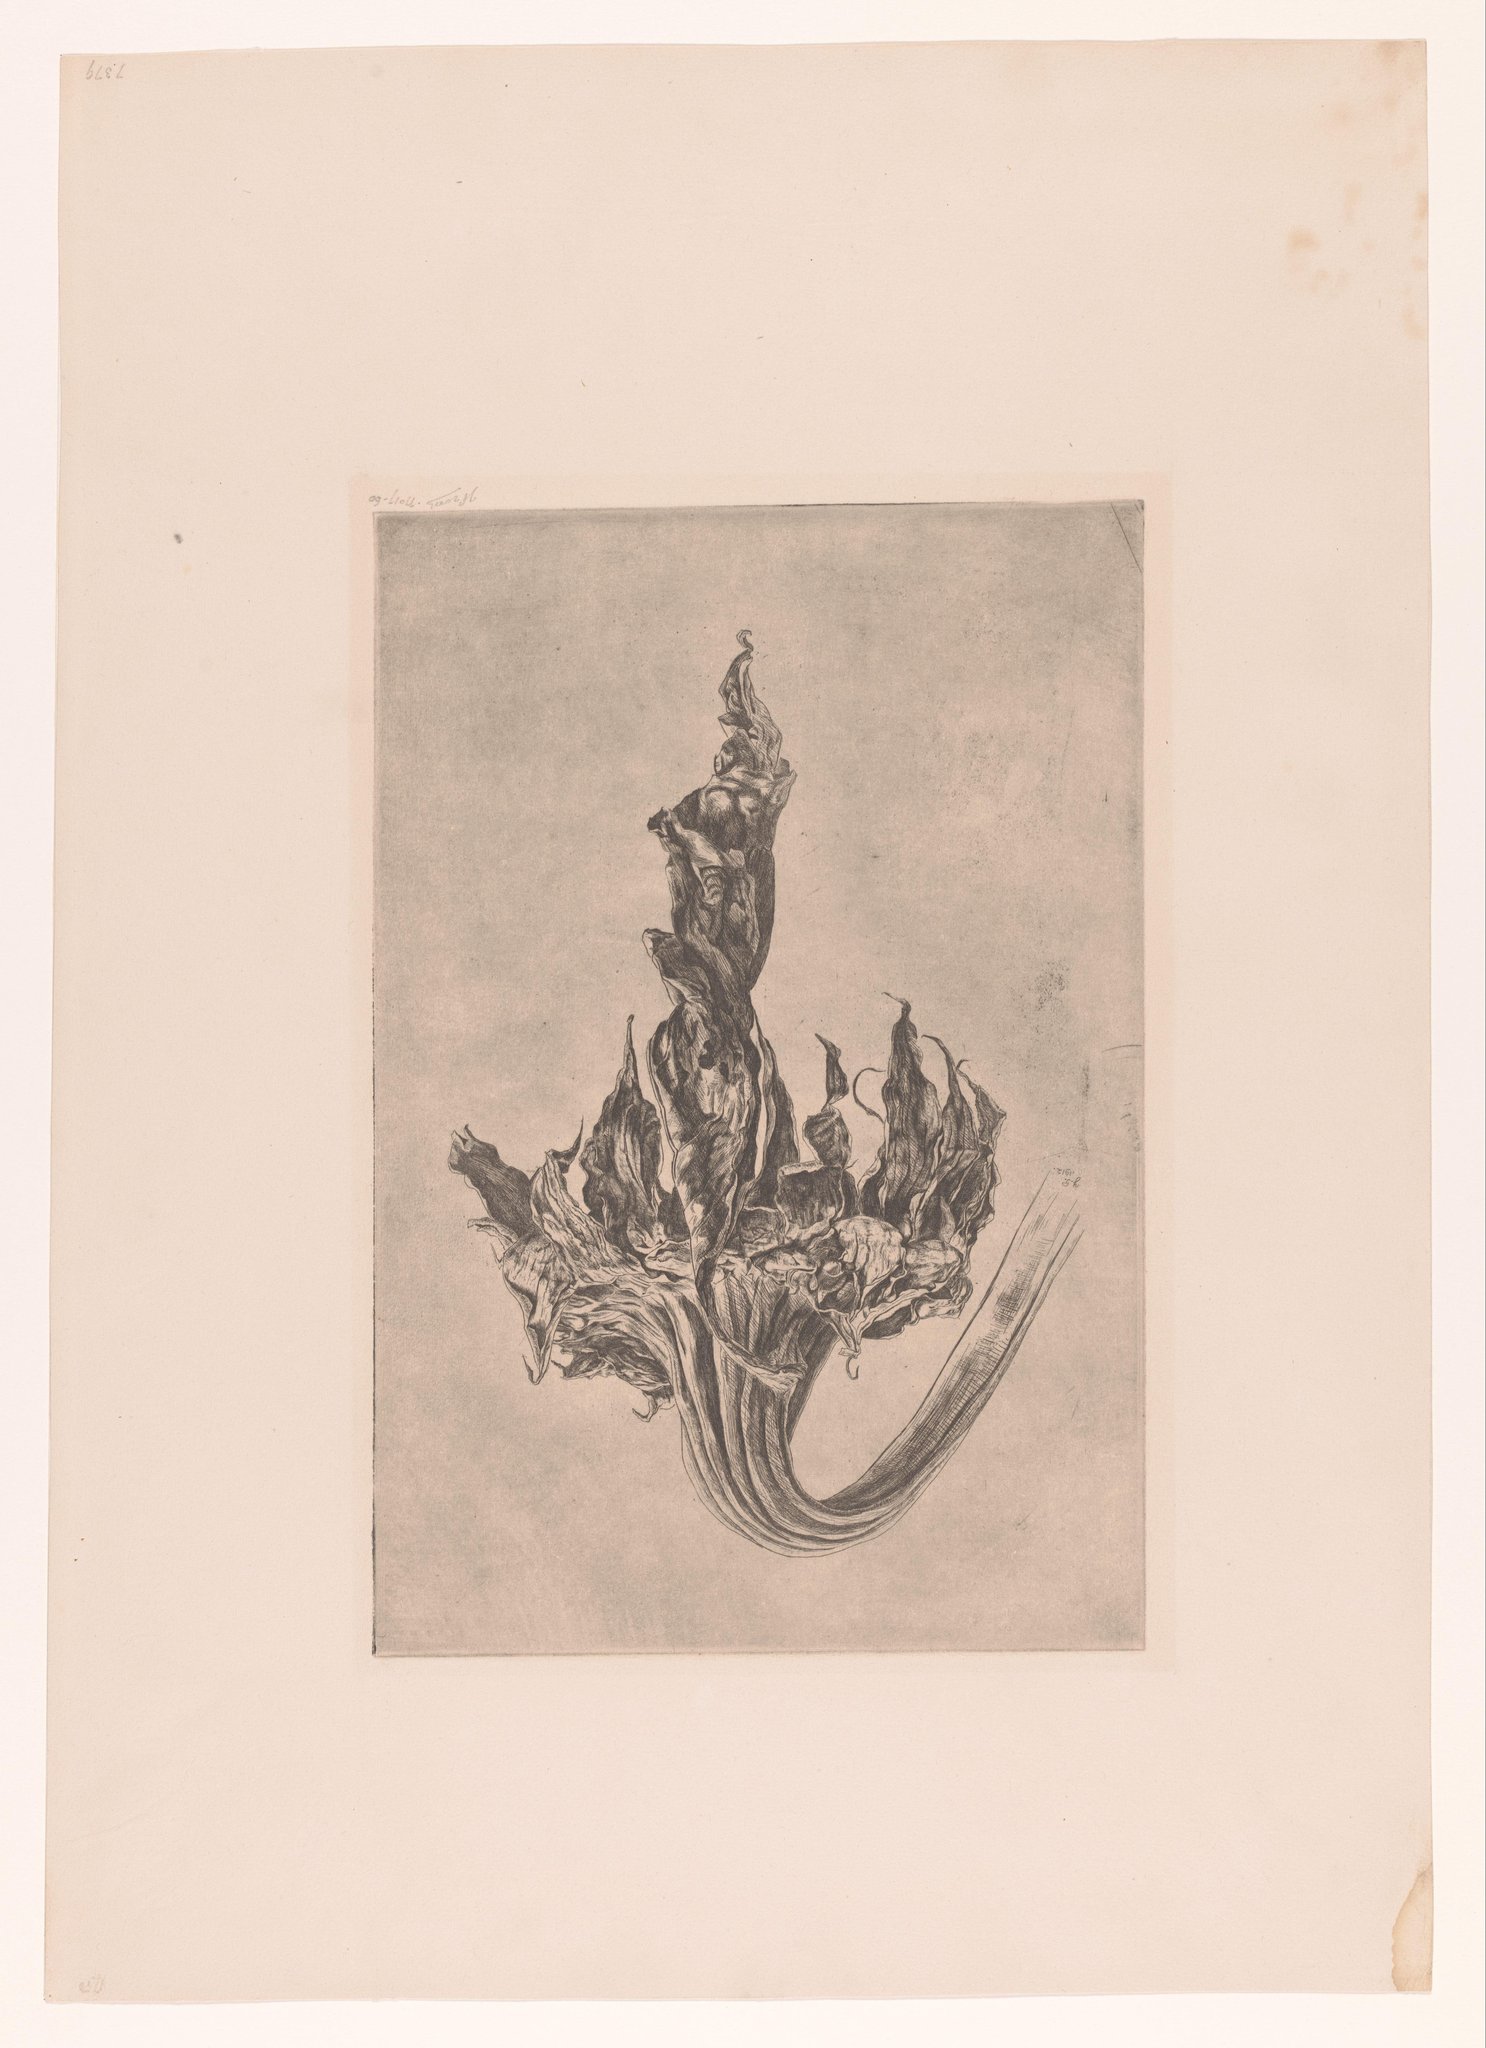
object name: print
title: Verdorde zonnebloem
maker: johannes proost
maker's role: print maker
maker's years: 1882-1942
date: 1892-1942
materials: paper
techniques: etching, intaglio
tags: flowers: sunflower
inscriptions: collector's mark: Lugt 2228